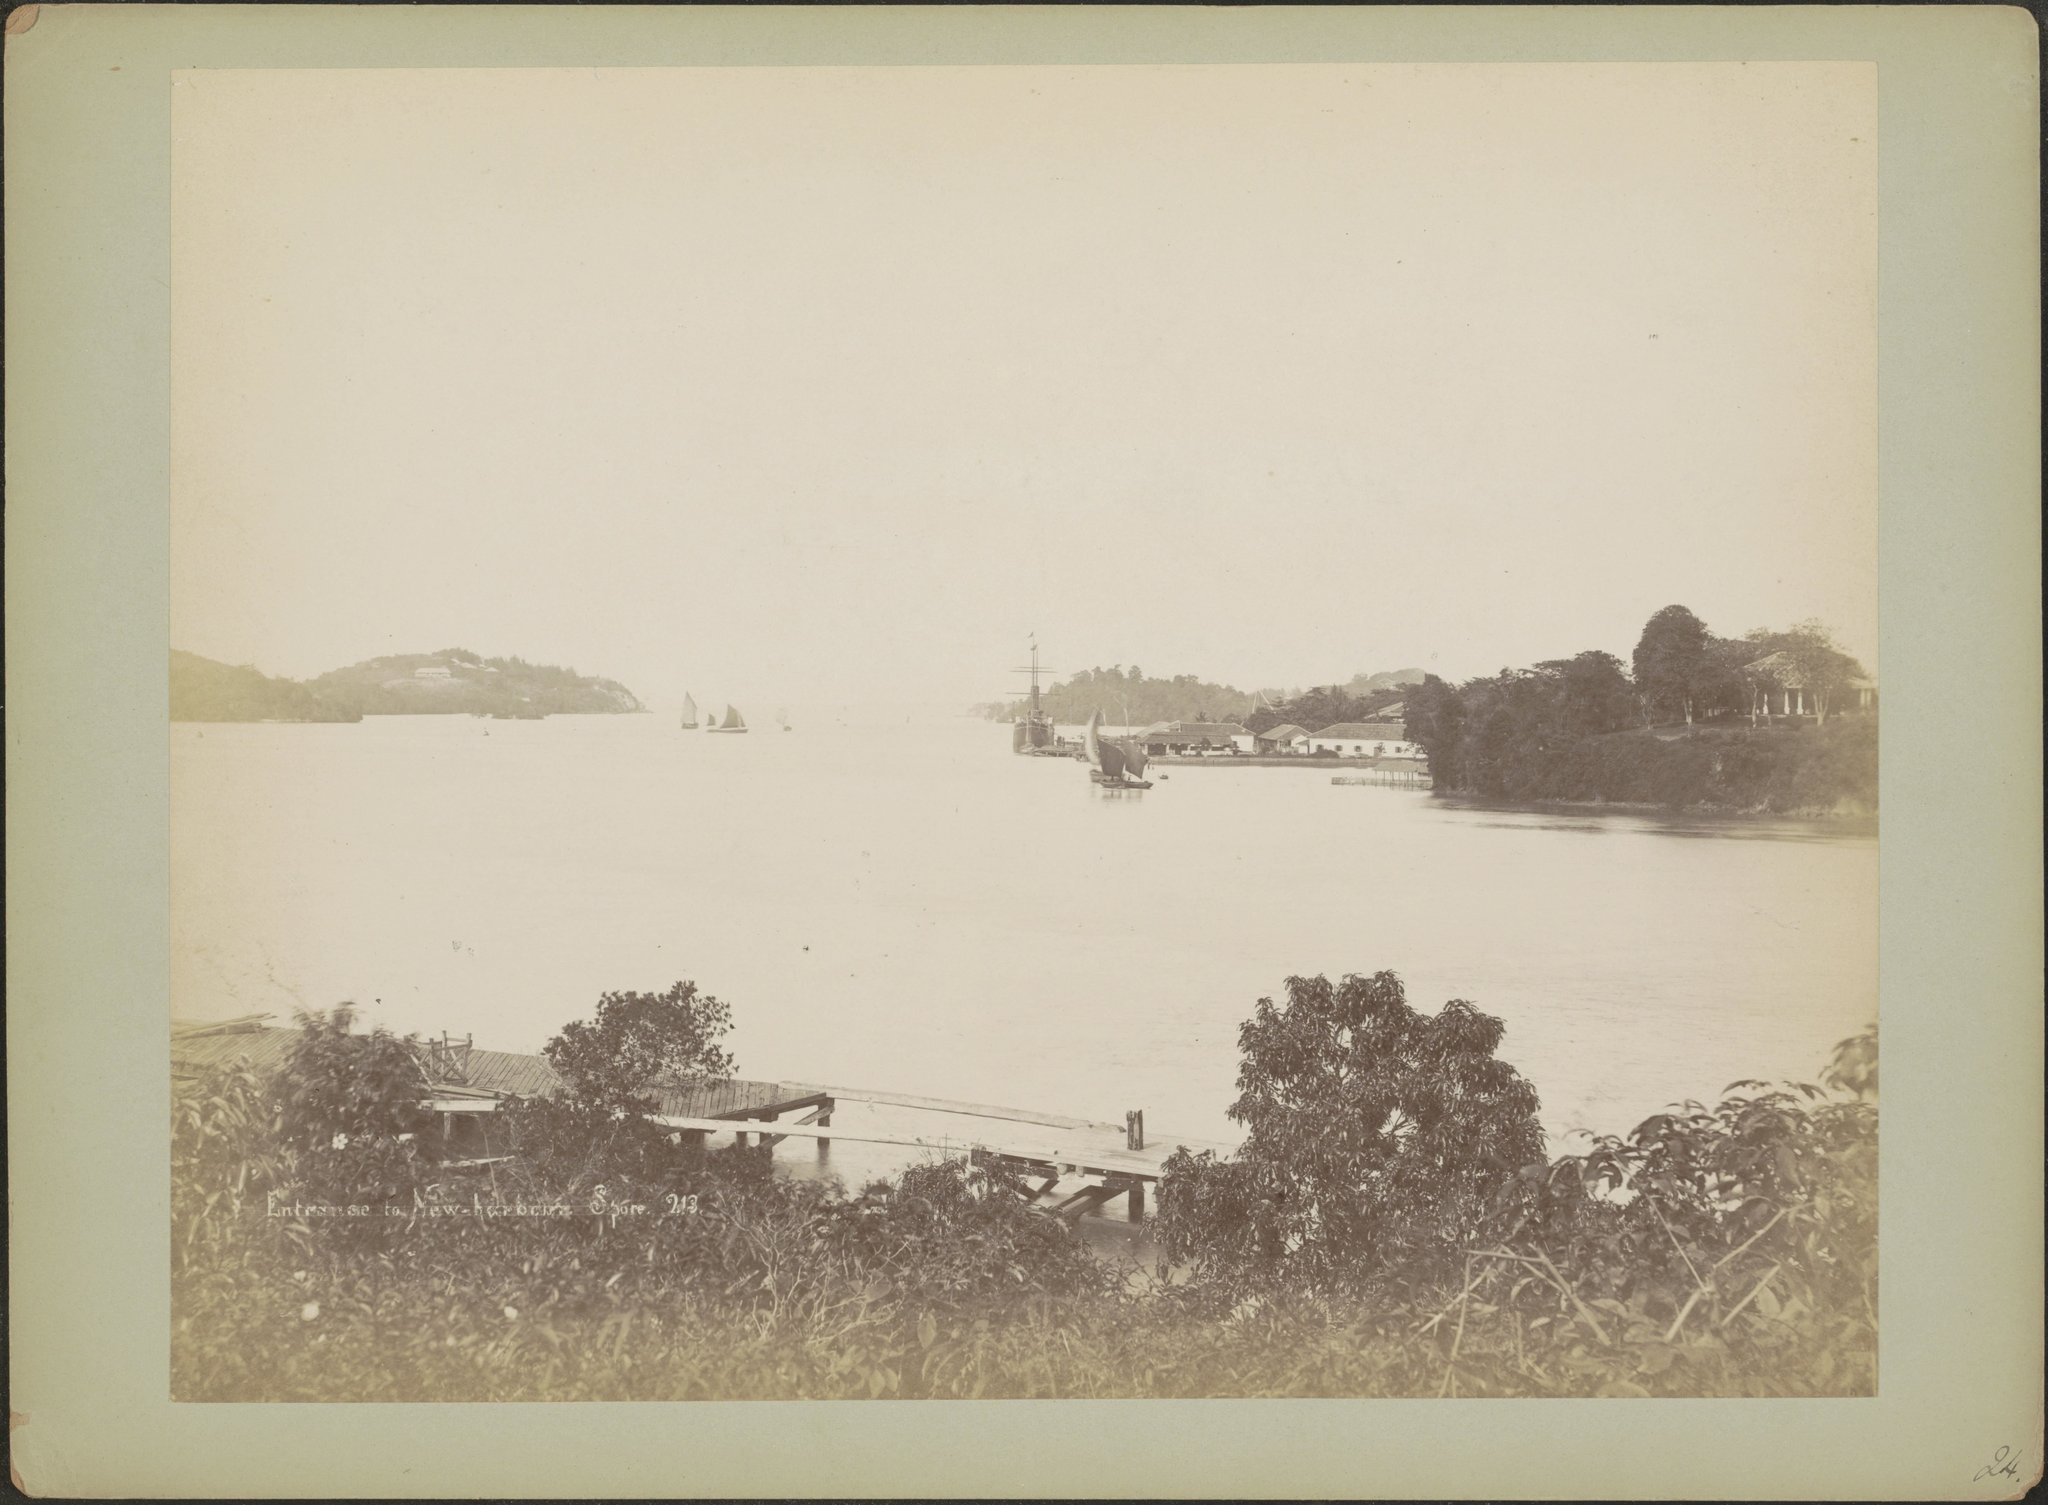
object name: album leaf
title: Entrance to New-harbour. S.pore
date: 1870-1910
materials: cardboard, paper, photographic support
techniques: albumen print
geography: singapore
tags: harbour (+ view ~ vehicle, ship, etc.), singapore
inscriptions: inscription: ‘[...]’, number: ‘213’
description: Onderdeel van Reisalbum met foto's van bezienswaardigheden in Marseille, Port Said, Aden, Bombay, Colombo, Singapore en Nederlands-Indië.